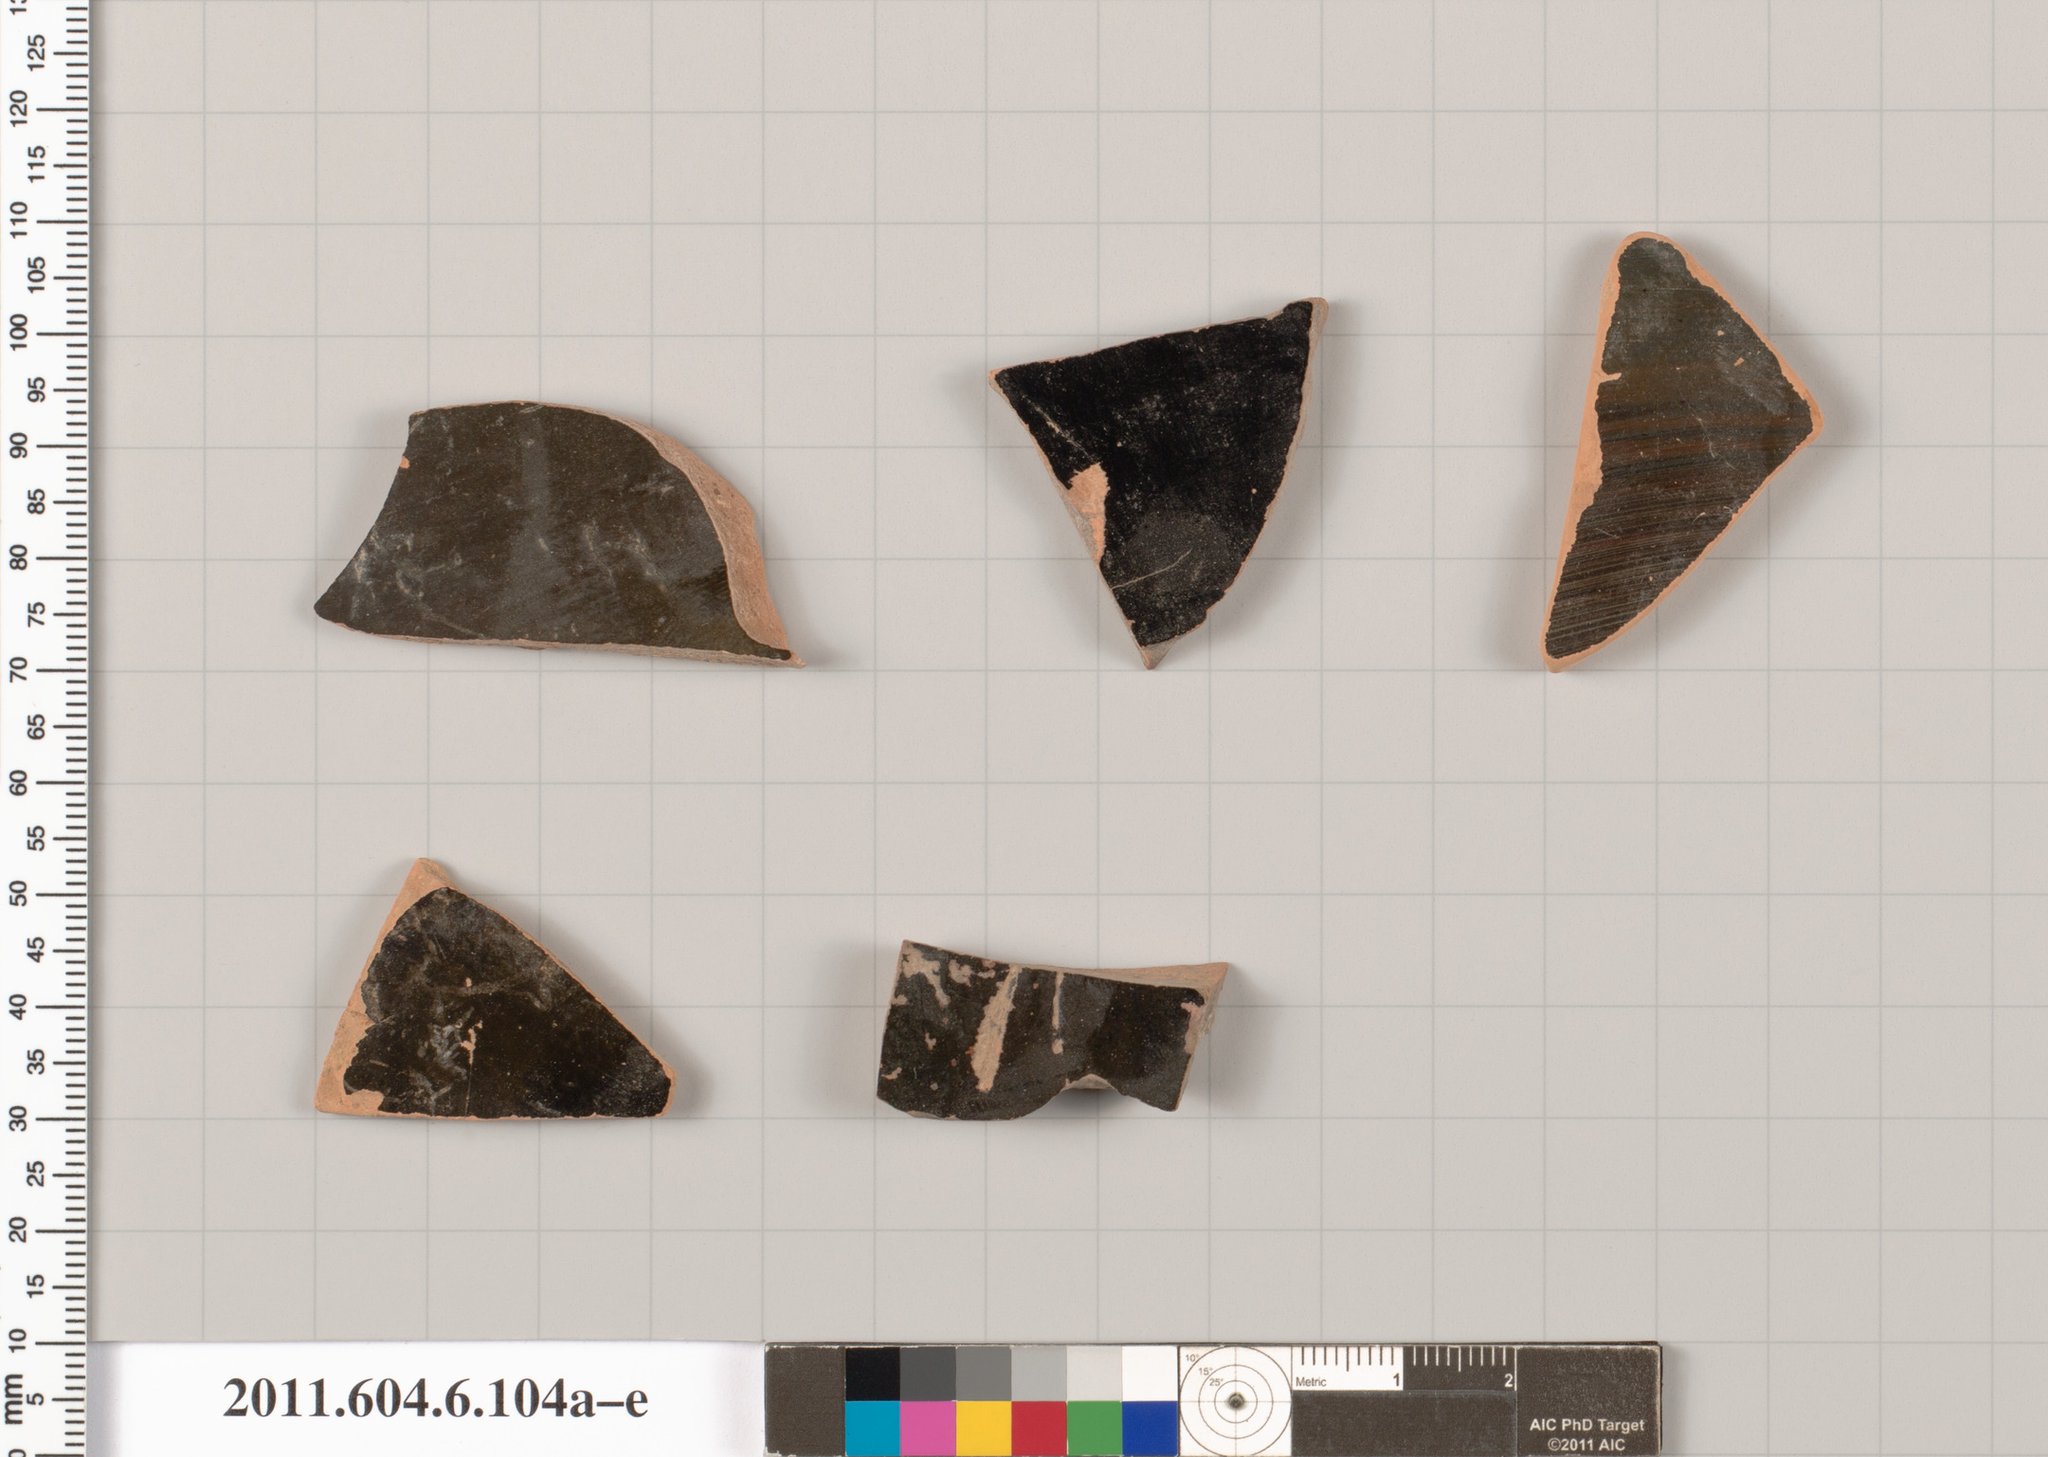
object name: undetermined closed shape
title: Terracotta fragments of closed shapes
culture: greek, attic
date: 600-401 BCE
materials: terracotta